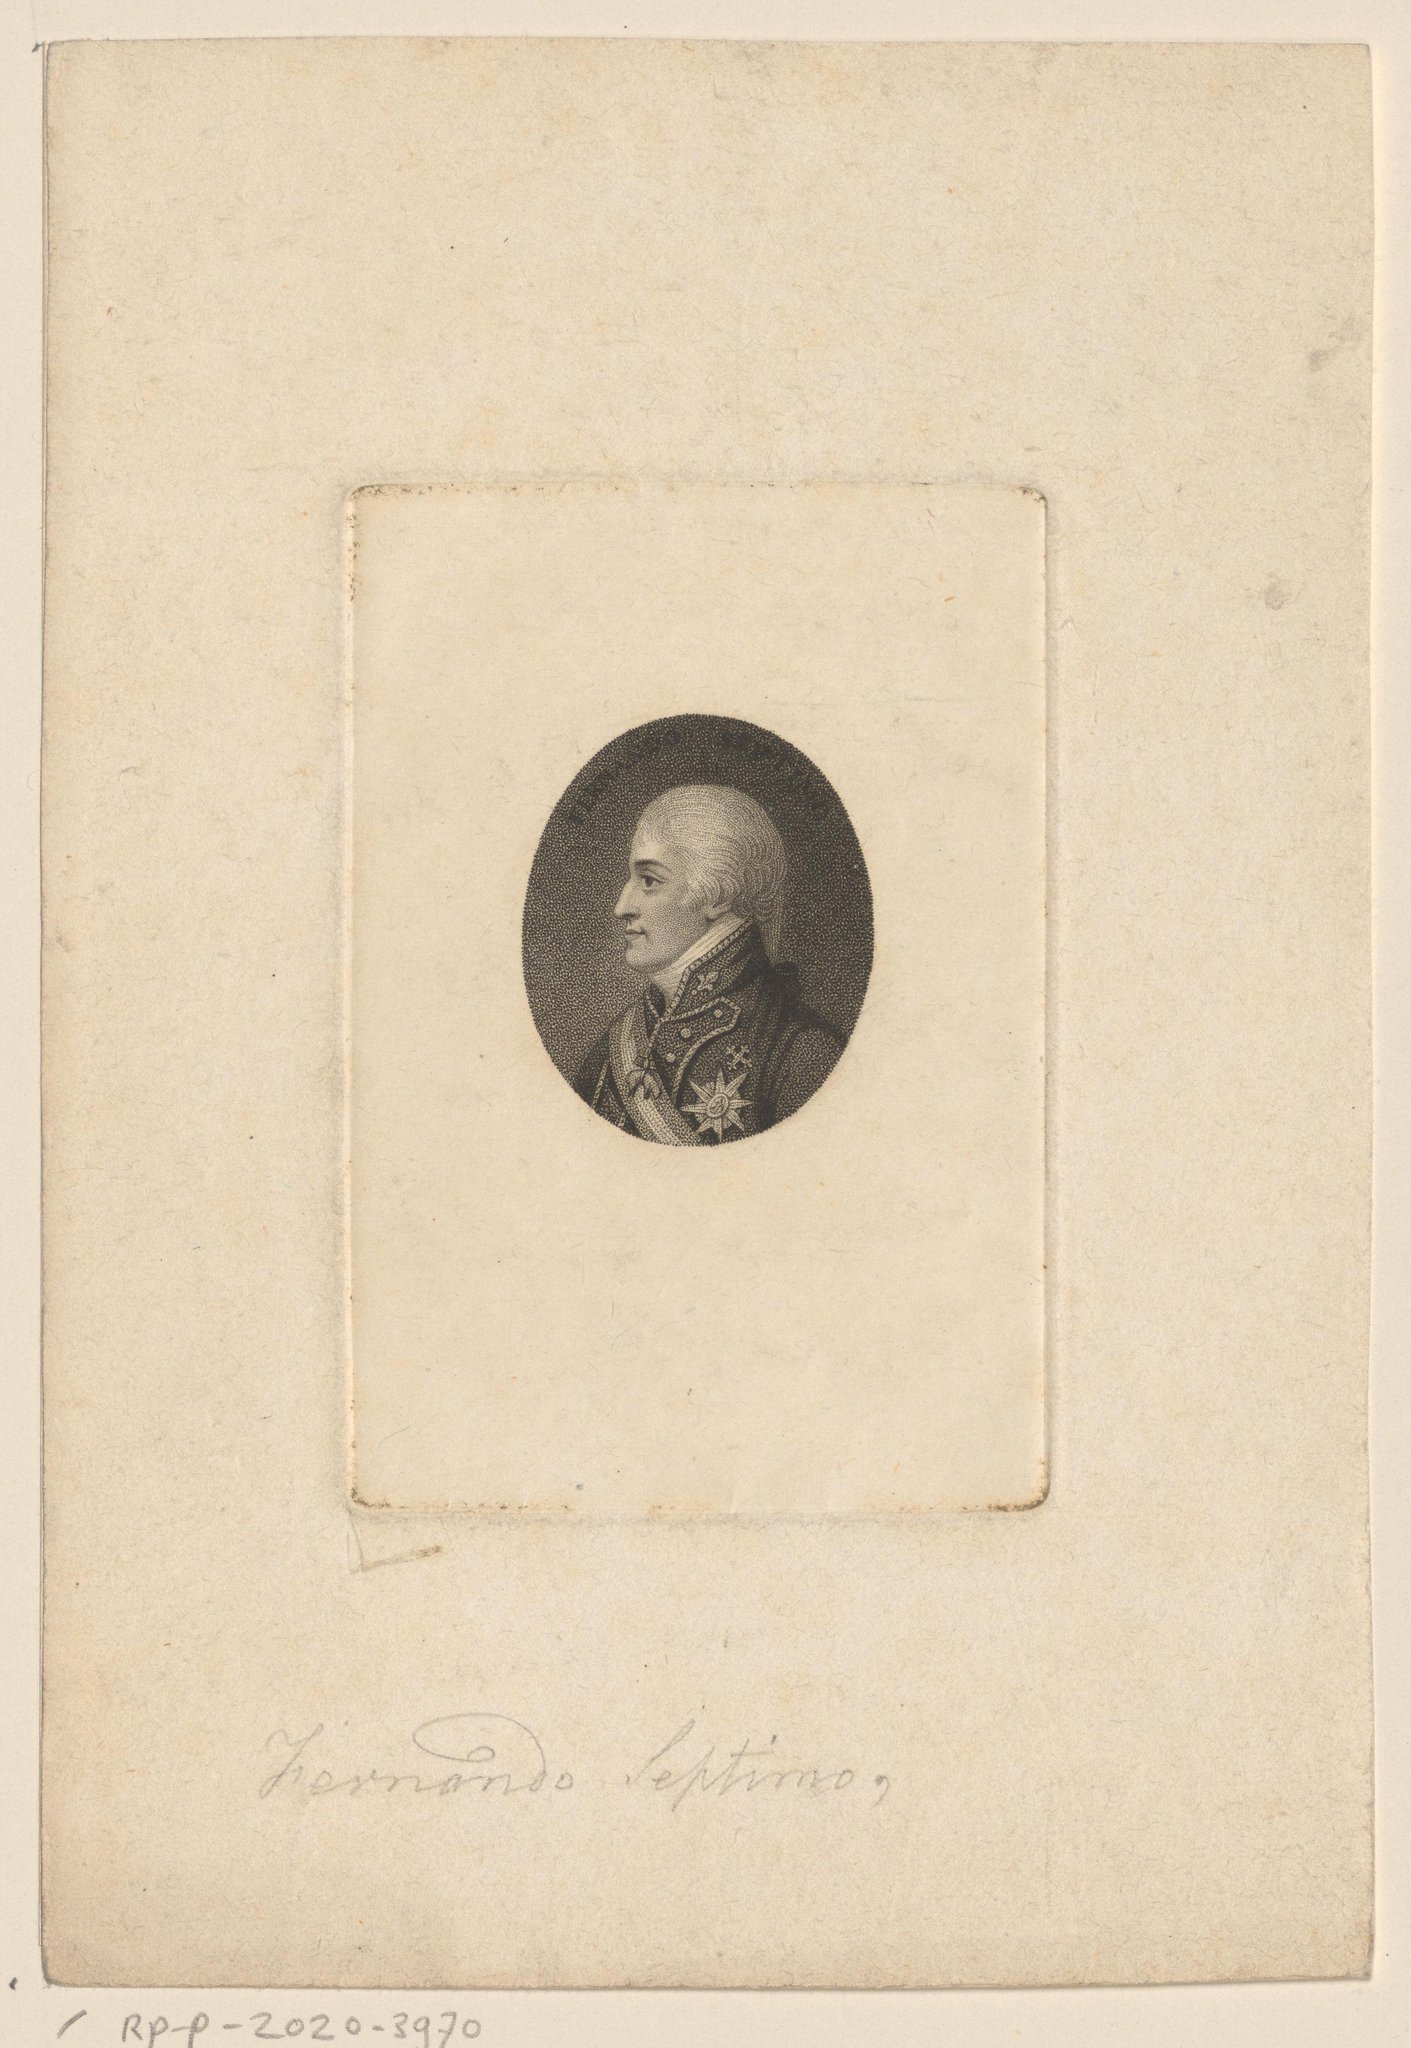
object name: print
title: Portret van Ferdinand VII van Spanje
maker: Anonymous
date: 1814-1850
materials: paper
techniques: etching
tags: ferdinand vii (koning van spanje), historical persons, king